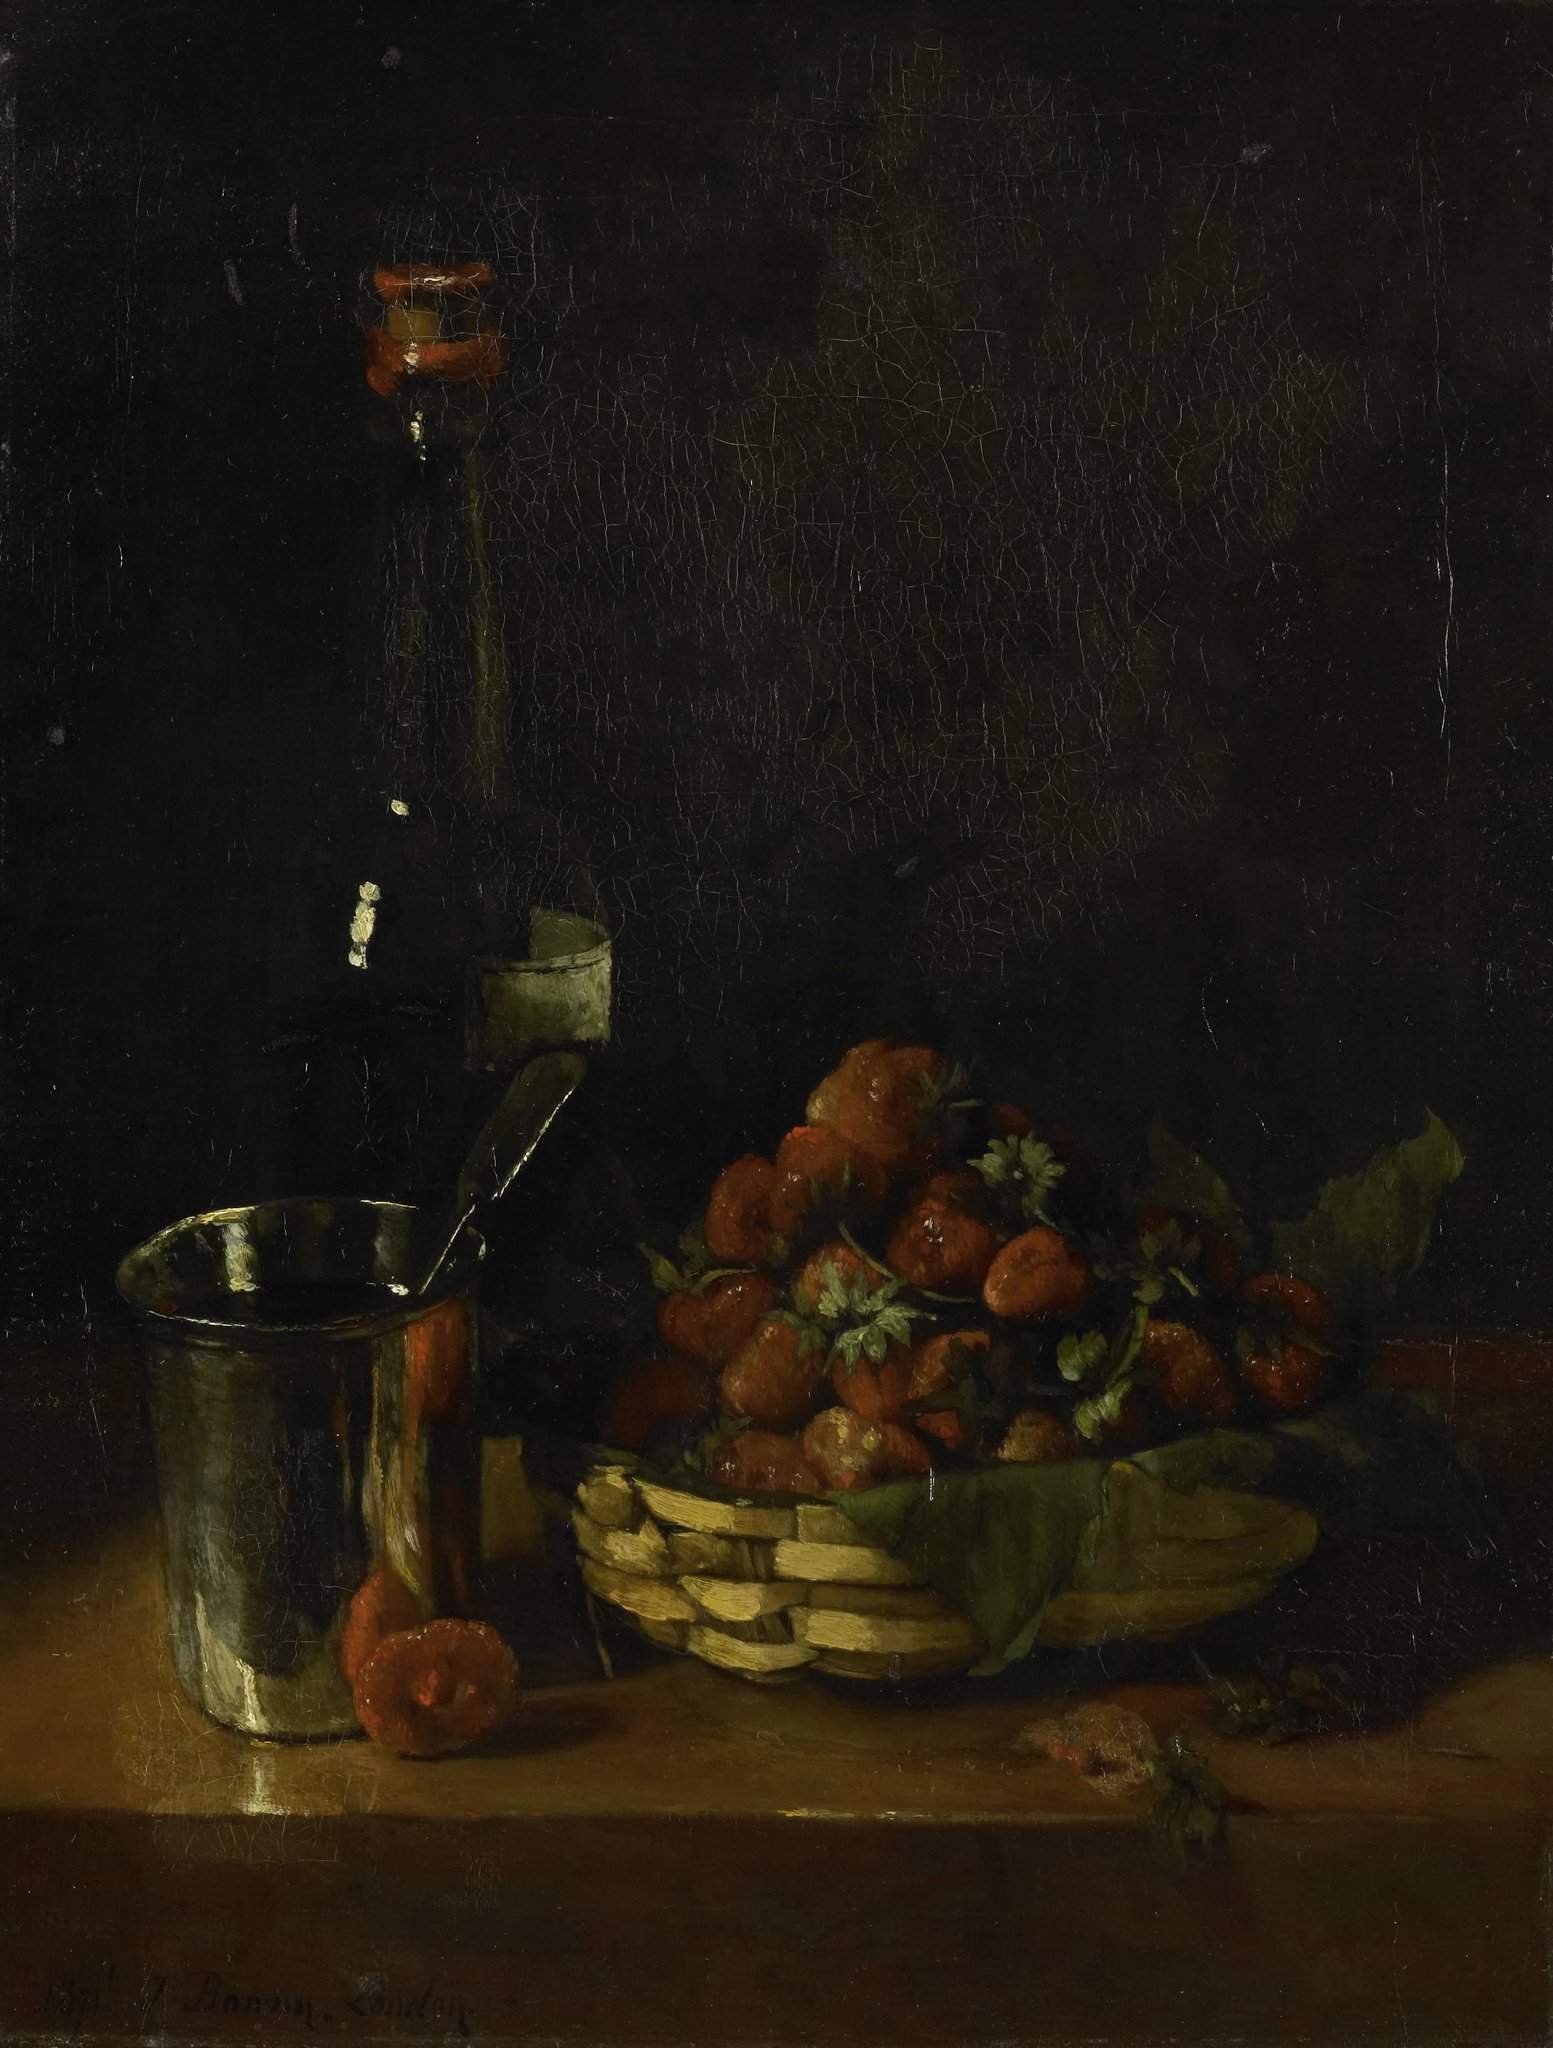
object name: painting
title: Still life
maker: françois bonvin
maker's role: draughtsman, print maker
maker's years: 1817-1887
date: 1871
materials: canvas, oil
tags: fruits: strawberry, still life of related objects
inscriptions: signature, date and inscription: ‘1871. F. Bonvin. London.’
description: Stilleven met een mandje aardbeien, een metalen beker met lepel en een fles.